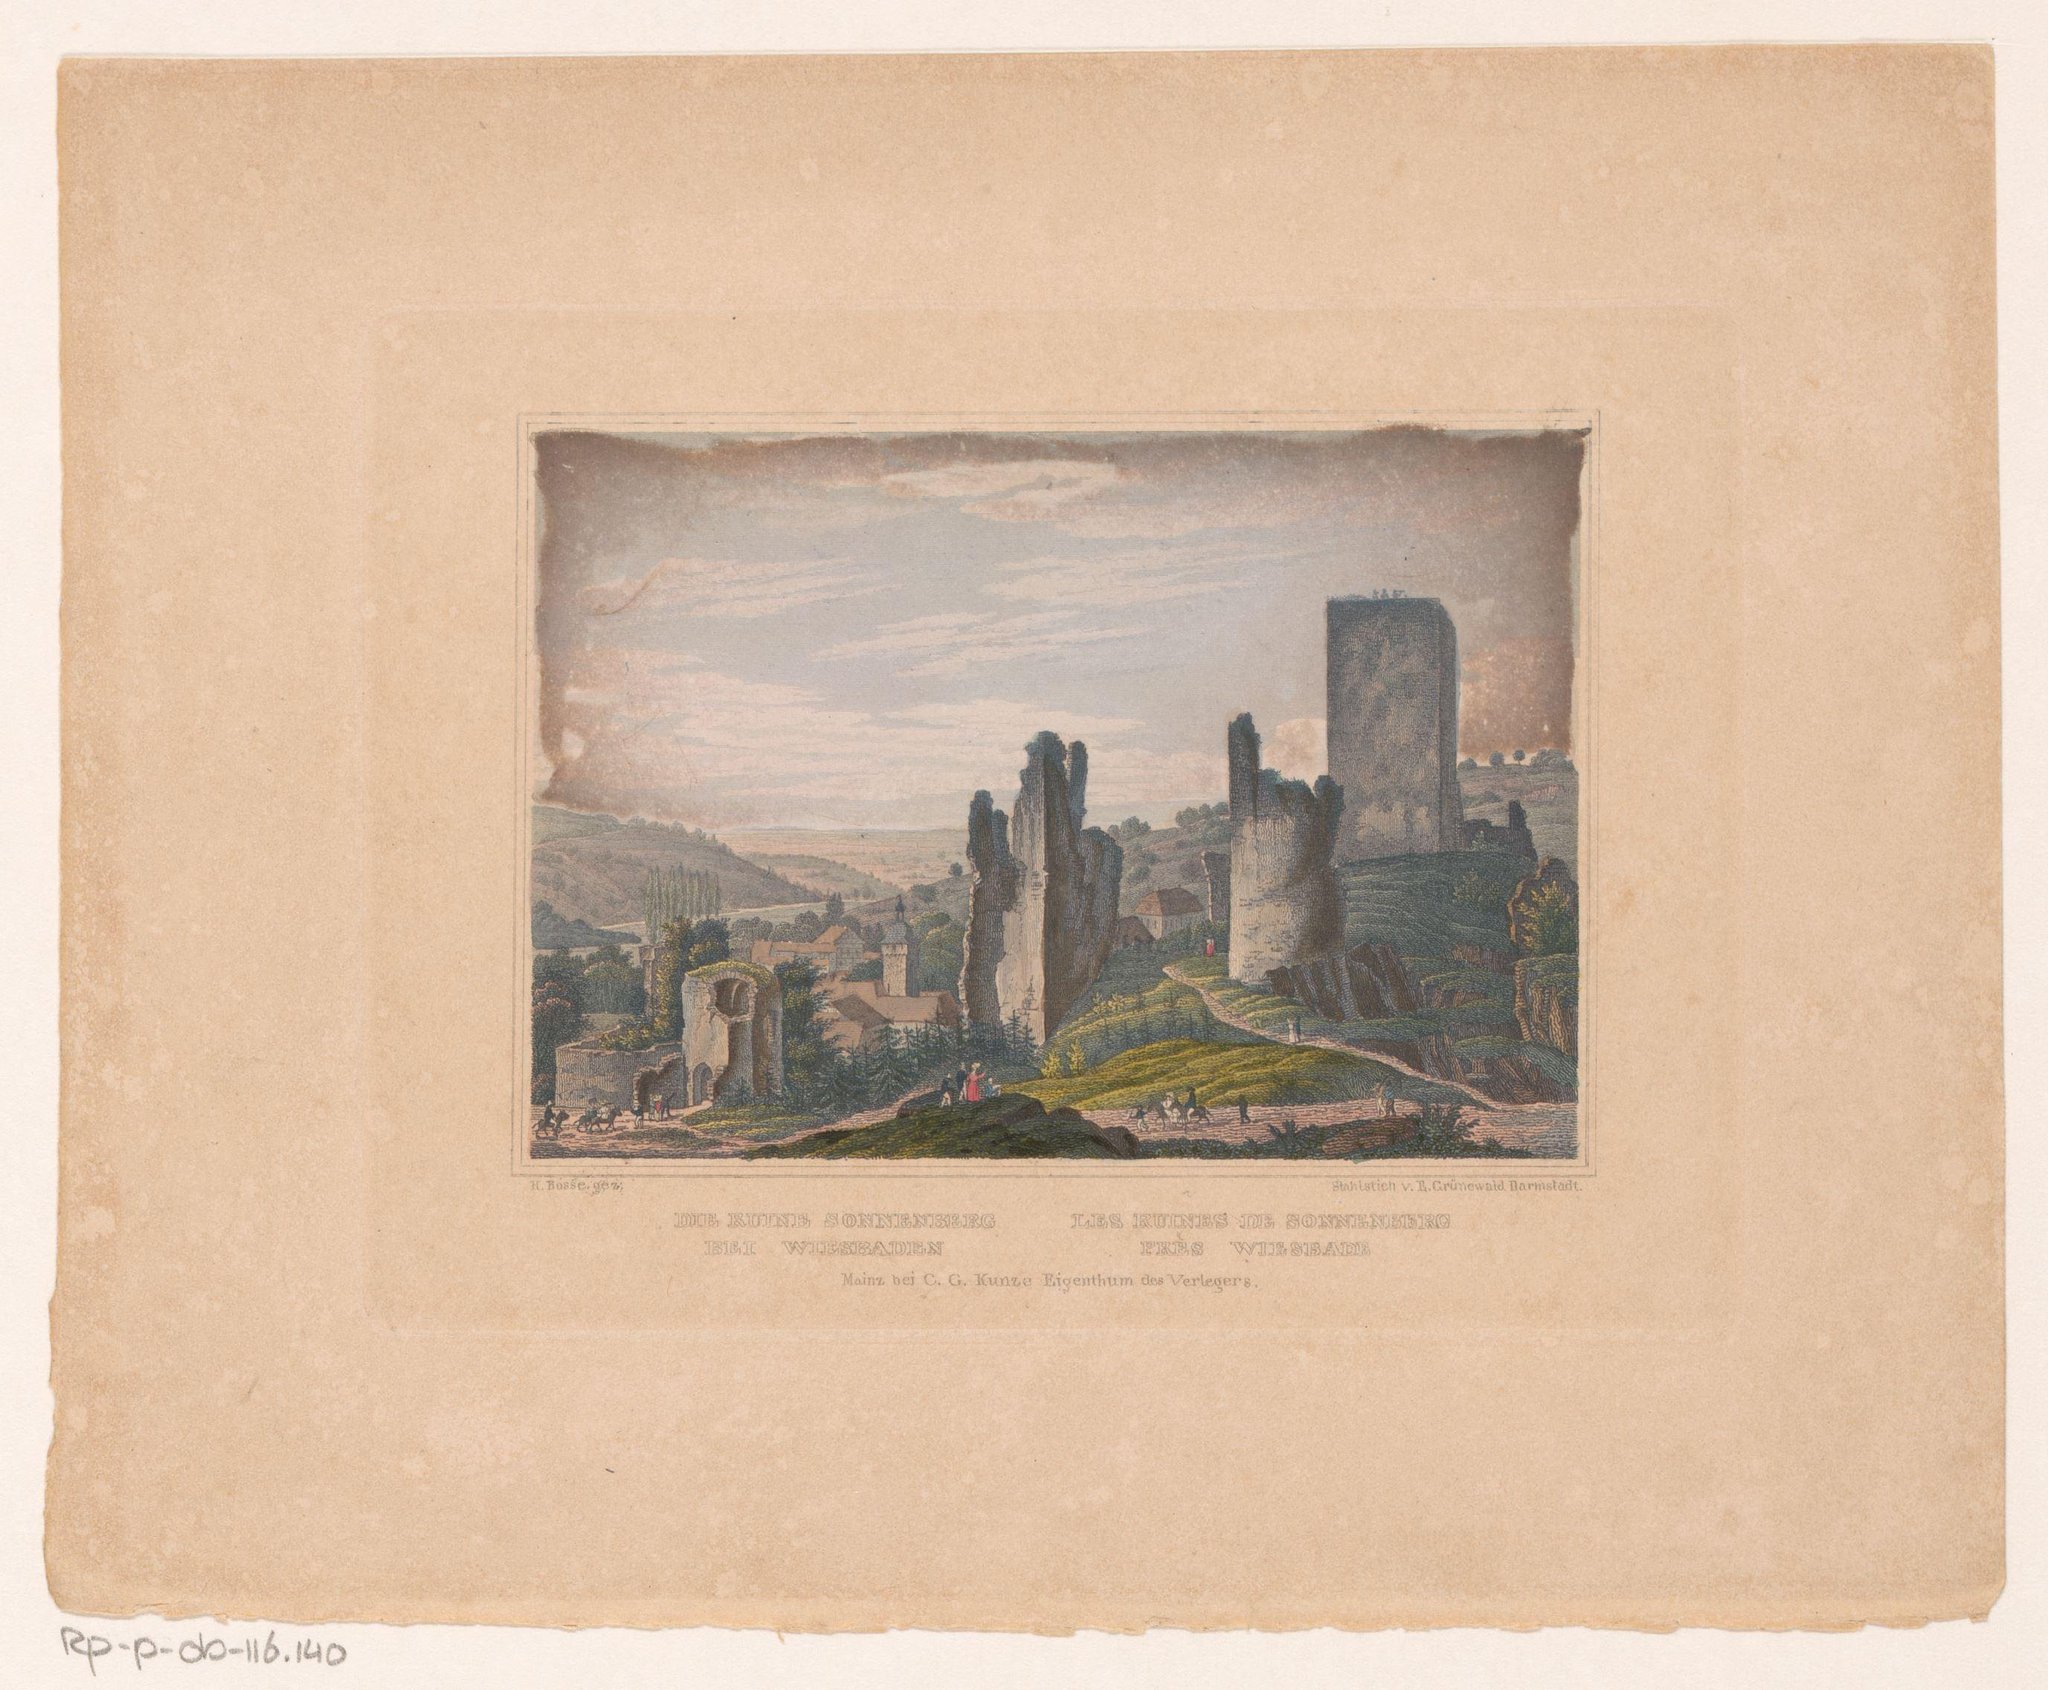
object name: print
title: Die Ruine Sonnenberg bei Wiesbaden / Les ruines de Sonnenberg près Wiesbade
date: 1811-1848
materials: paper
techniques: hand coloring, engraving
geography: darmstadt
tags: landscape with ruins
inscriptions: collector's mark: Lugt 2228